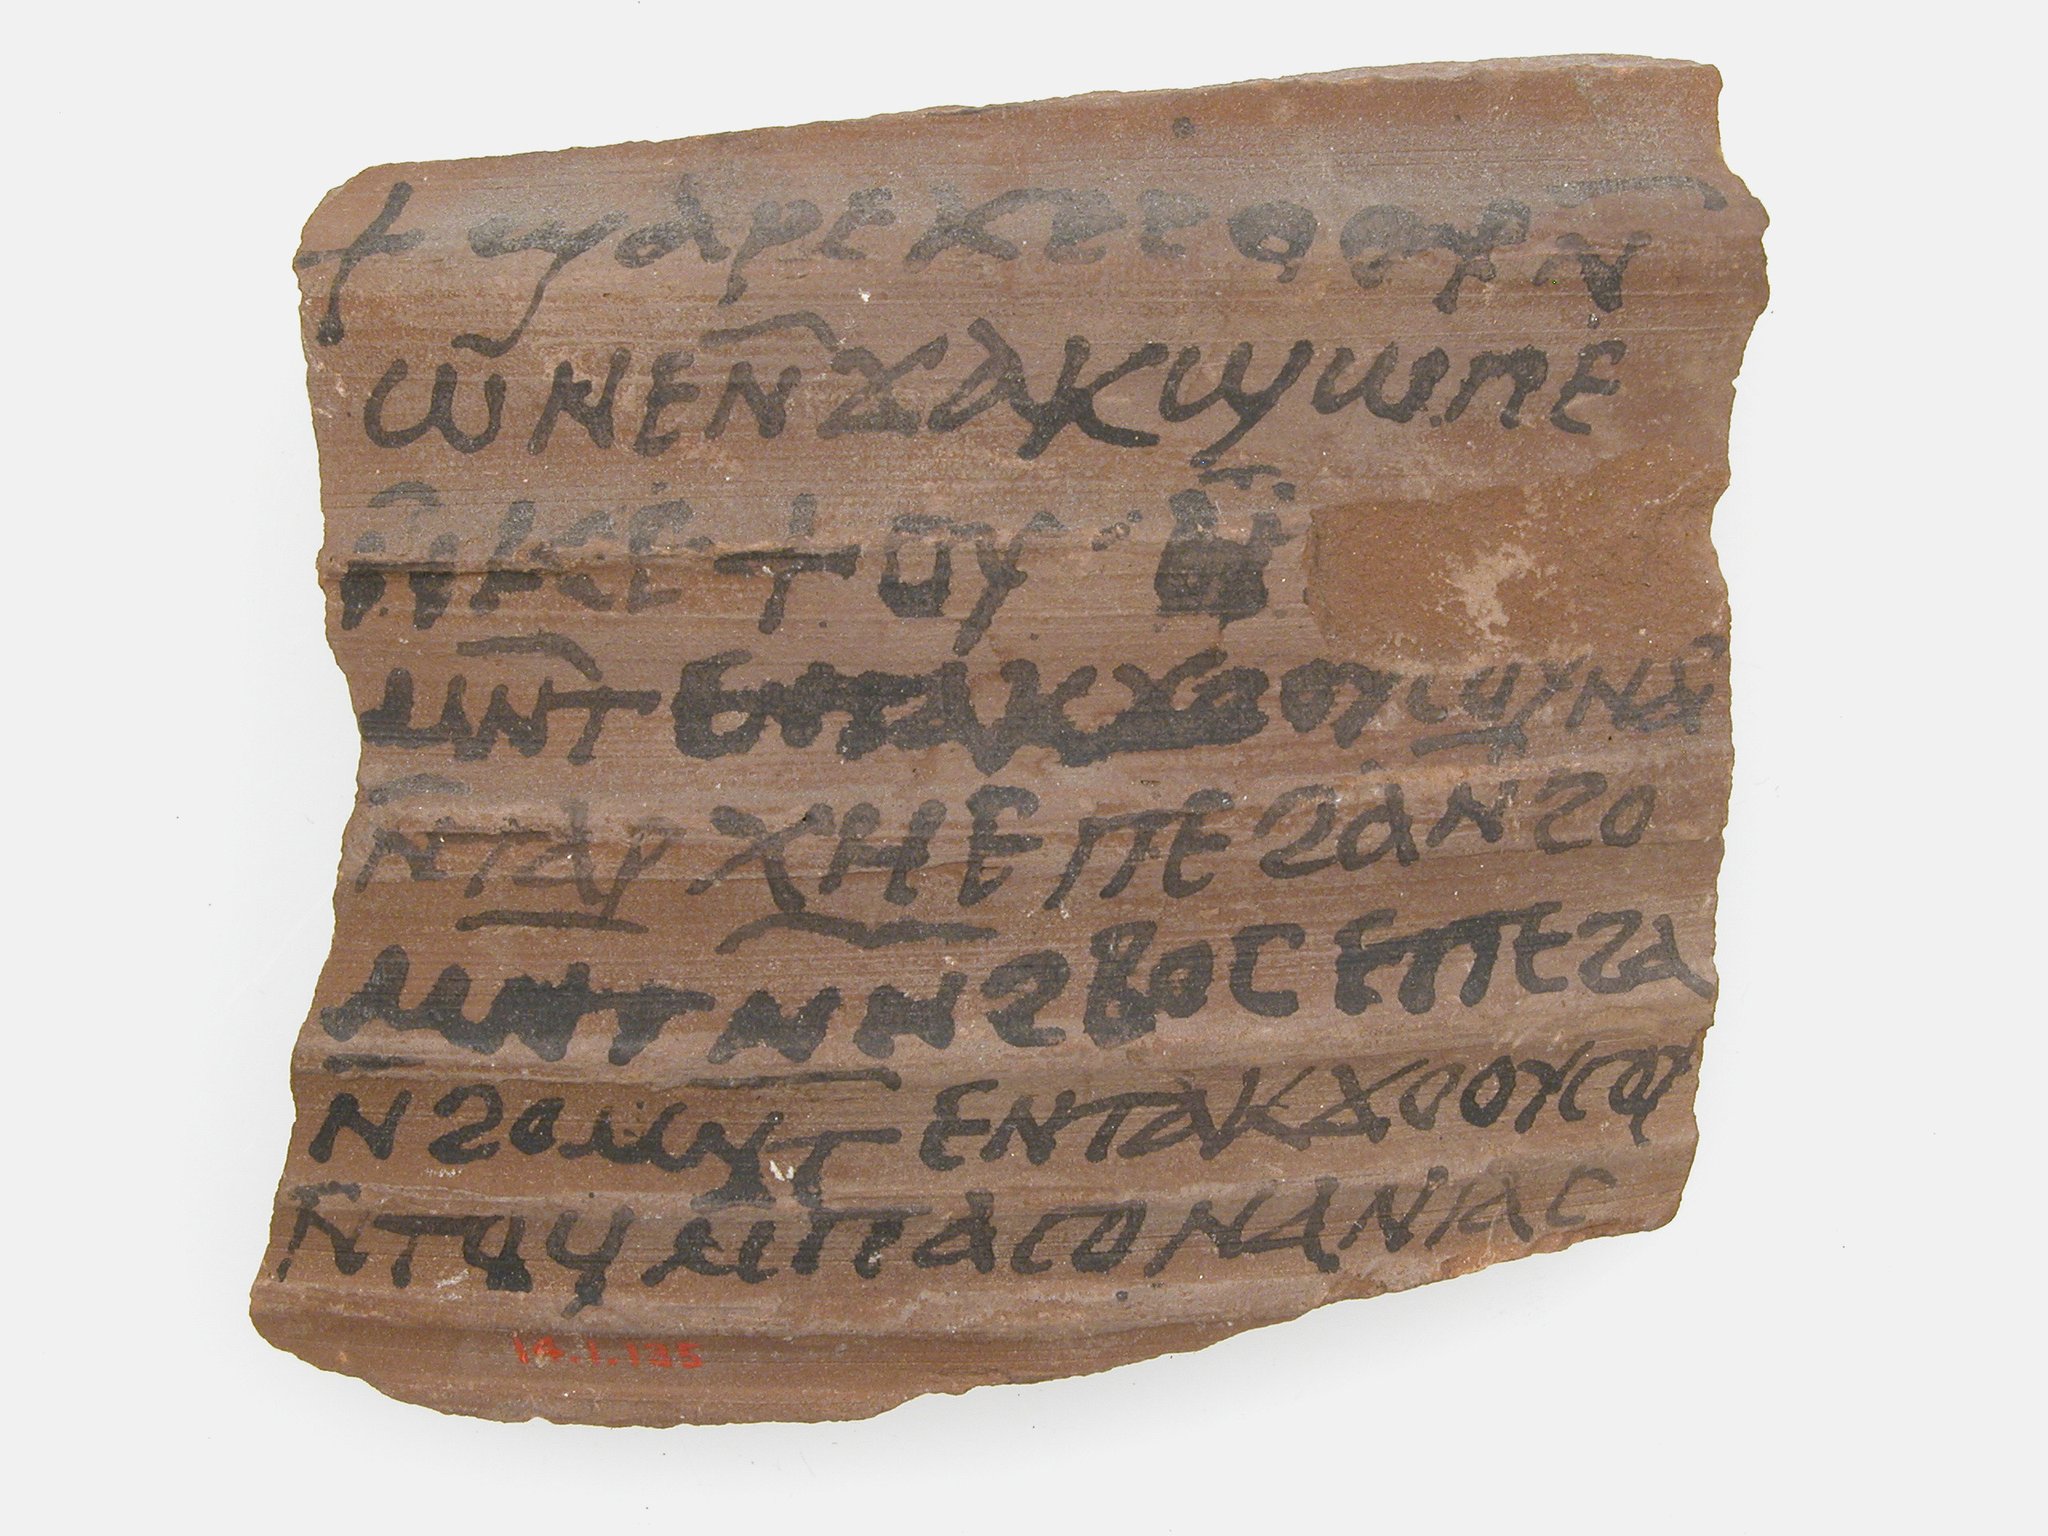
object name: ostrakon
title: Ostrakon with a Letter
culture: coptic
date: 600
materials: ink, pottery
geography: egypt